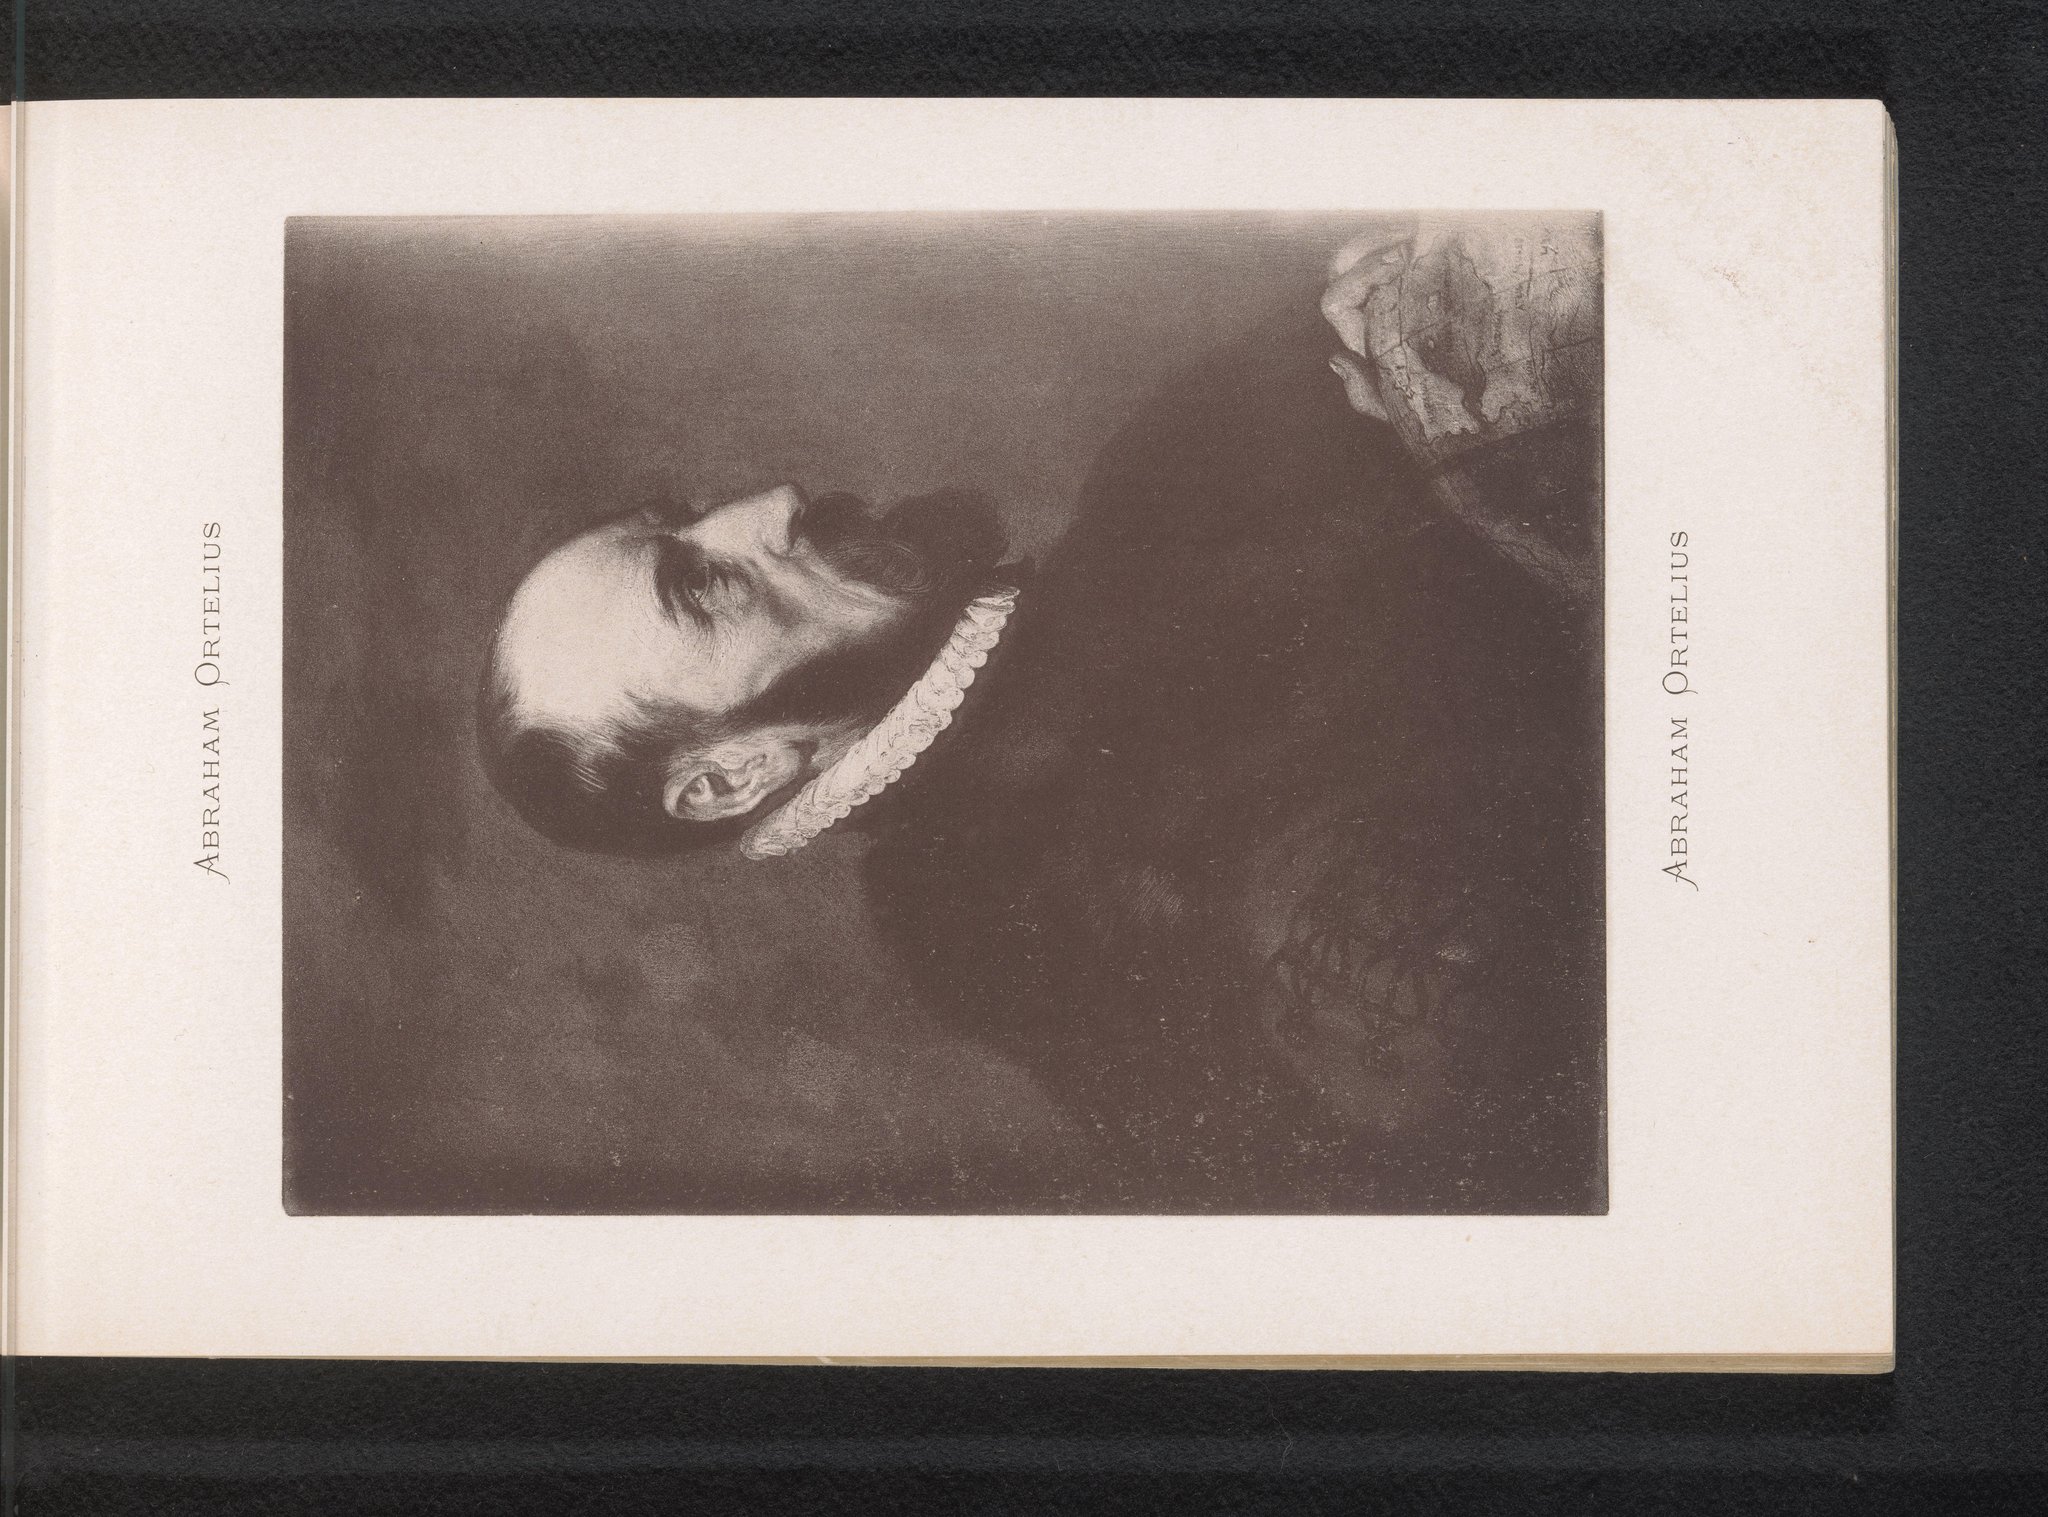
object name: photomechanical print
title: Abraham Ortelius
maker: Anonymous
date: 1892-1897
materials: paper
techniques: photograph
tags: antwerp, abraham ortelius, adult man